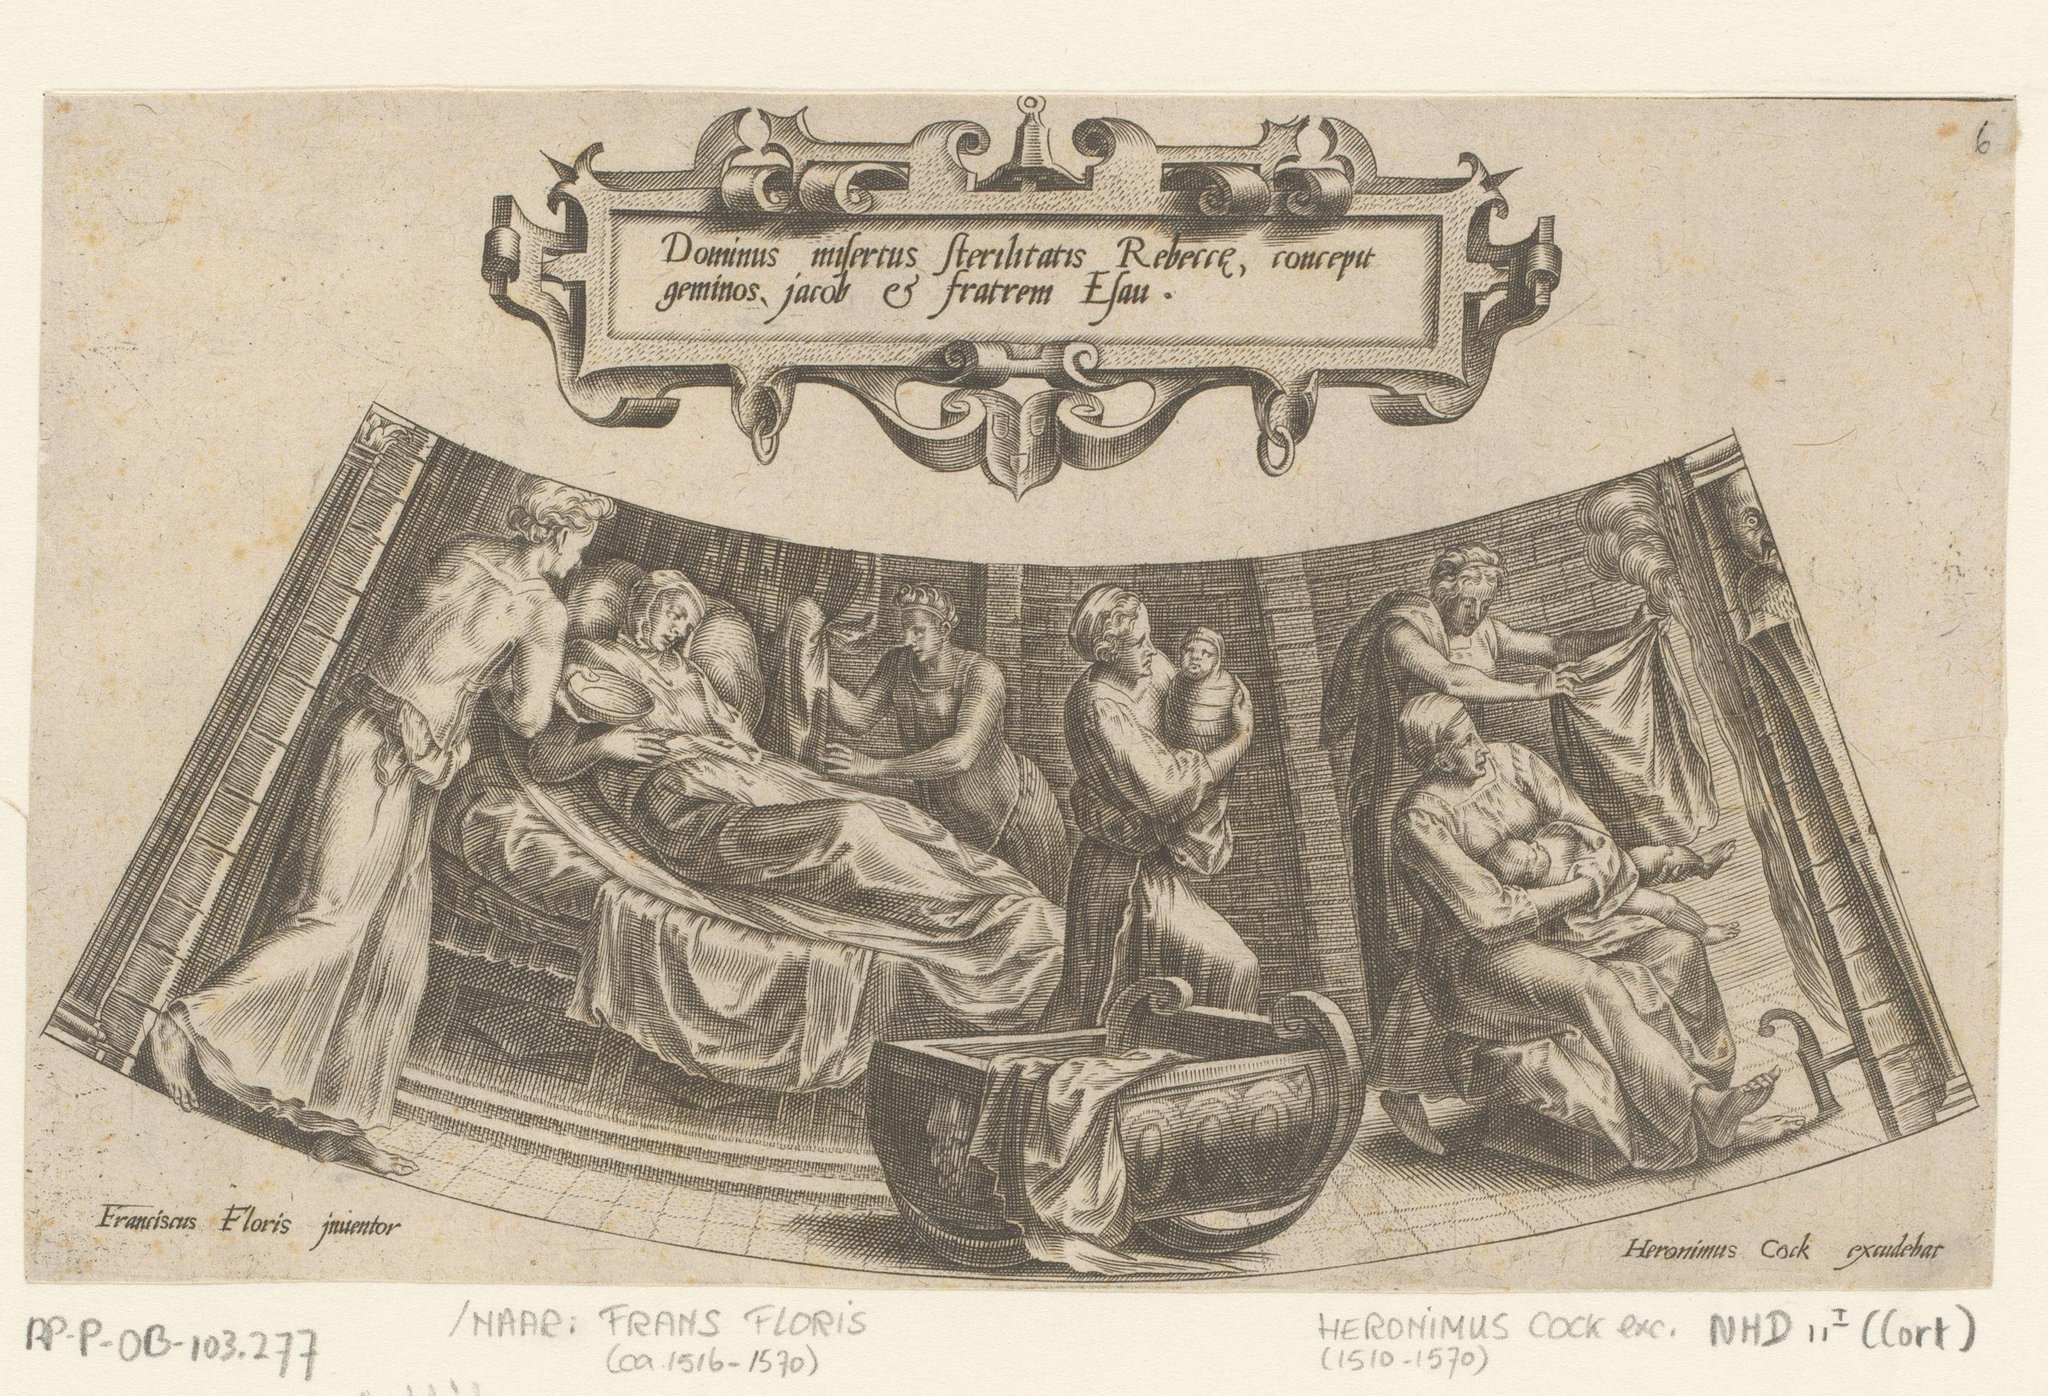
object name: print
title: Geschiedenis van Jakob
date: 1563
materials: paper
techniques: engraving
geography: antwerp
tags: birth of the twins: jacob clutches esau's heel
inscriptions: collector's mark: Lugt 2228, collector's mark: ‘[AP]’